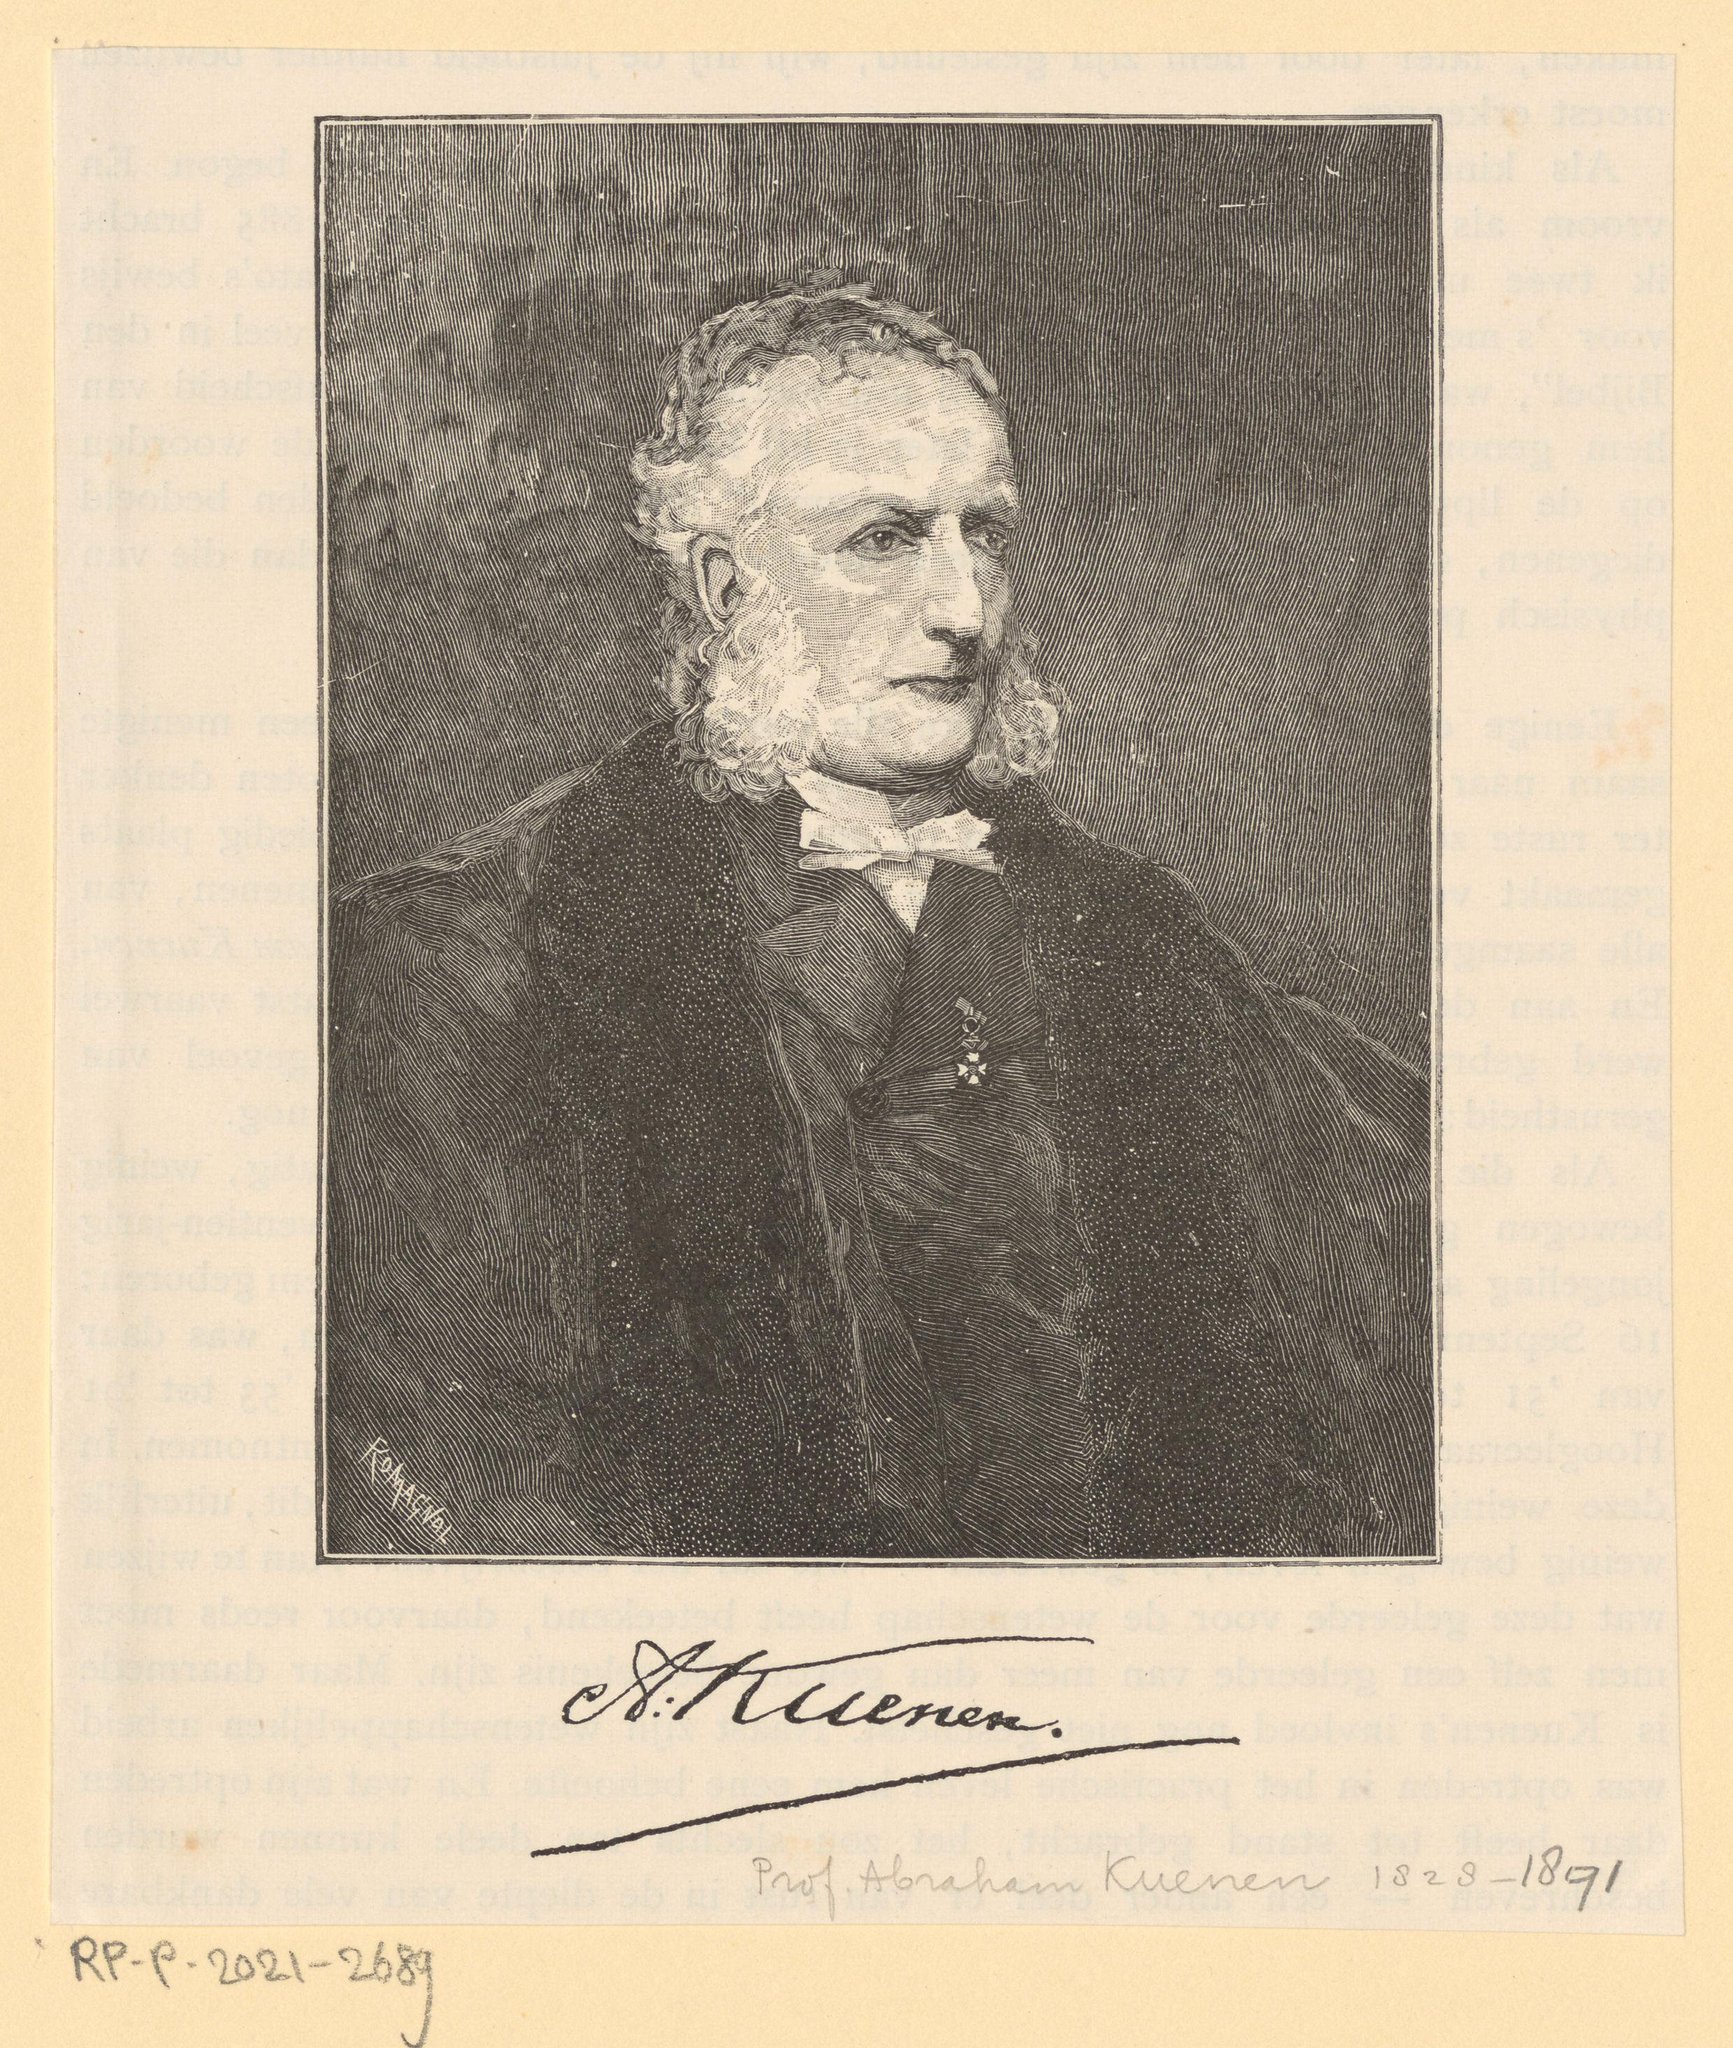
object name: print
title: Portret van Abraham Kuenen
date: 1892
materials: paper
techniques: letterpress printing, engraving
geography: amsterdam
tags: haarlem, leiden, historical persons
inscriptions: signature: ‘Romagnal’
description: Prent uit: Elsevier's Geïllustreerd Maandschrift 2, 1892.